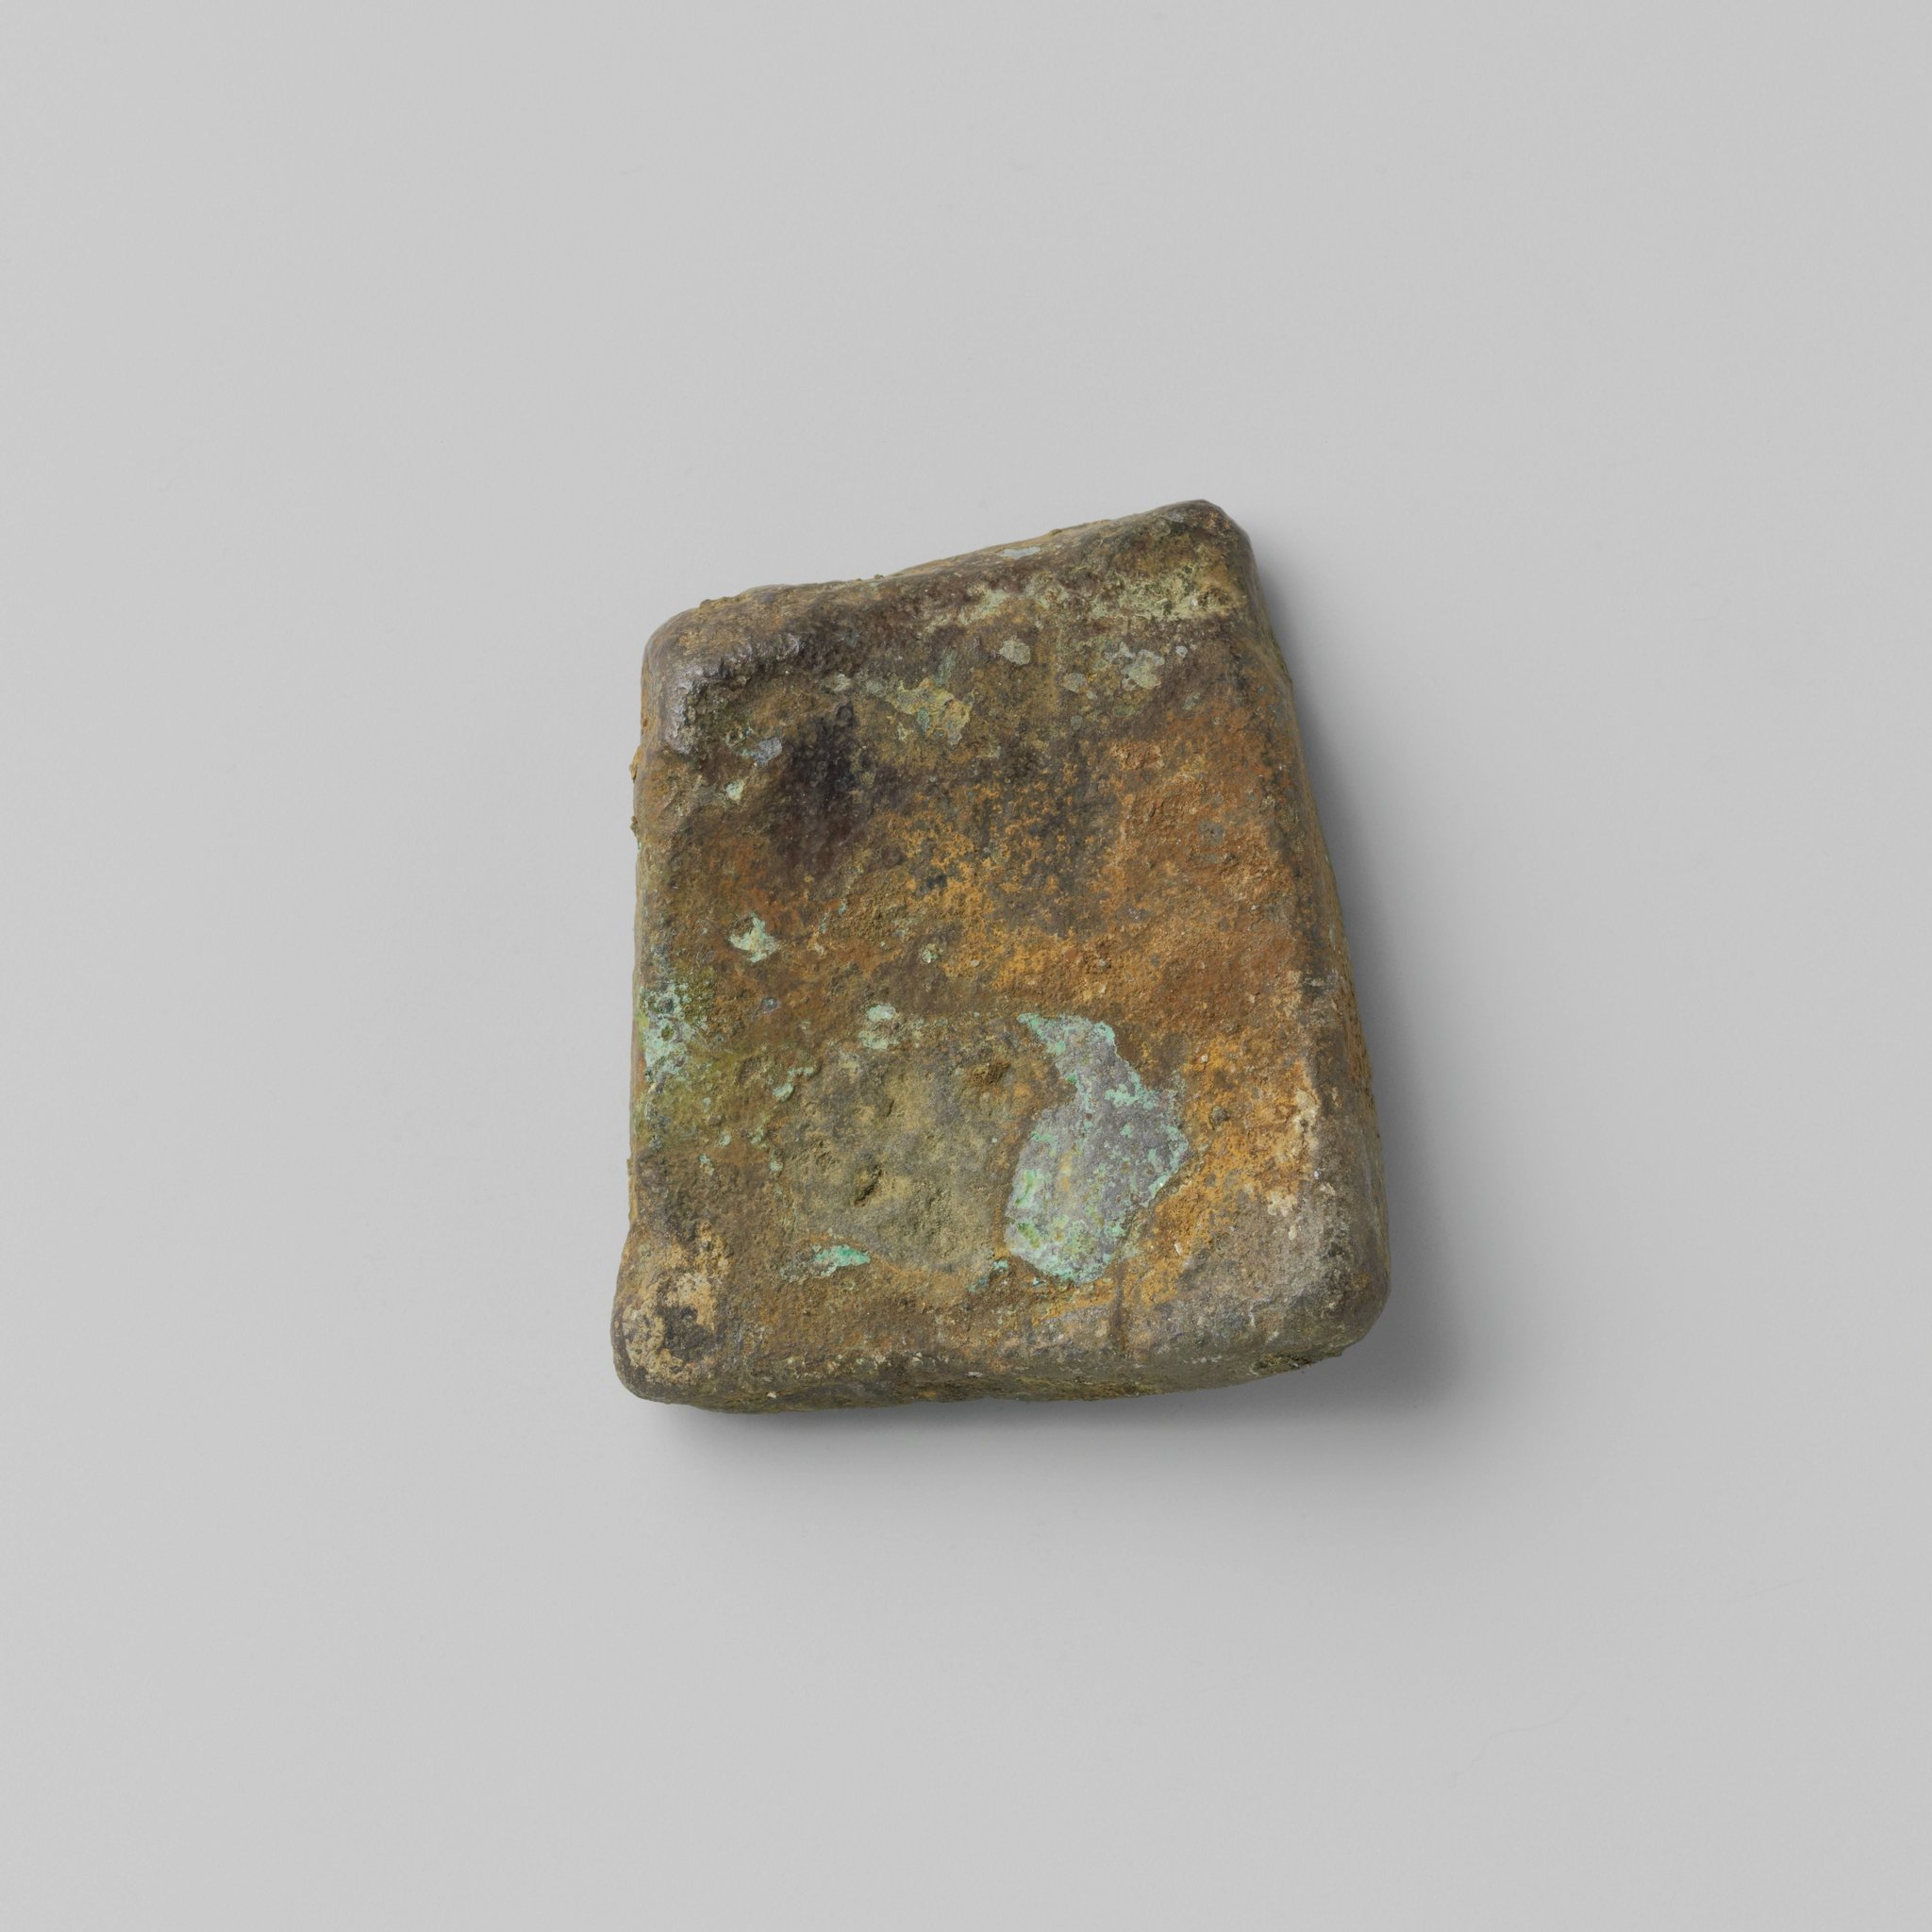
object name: percussion instrument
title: Fragment of a ship bell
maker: Anonymous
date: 1700-1743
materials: copper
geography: netherlands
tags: verenigde oostindische compagnie, hollandia (schip), annet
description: Acoustic, bell (ship's); fragment of body, very eroded.